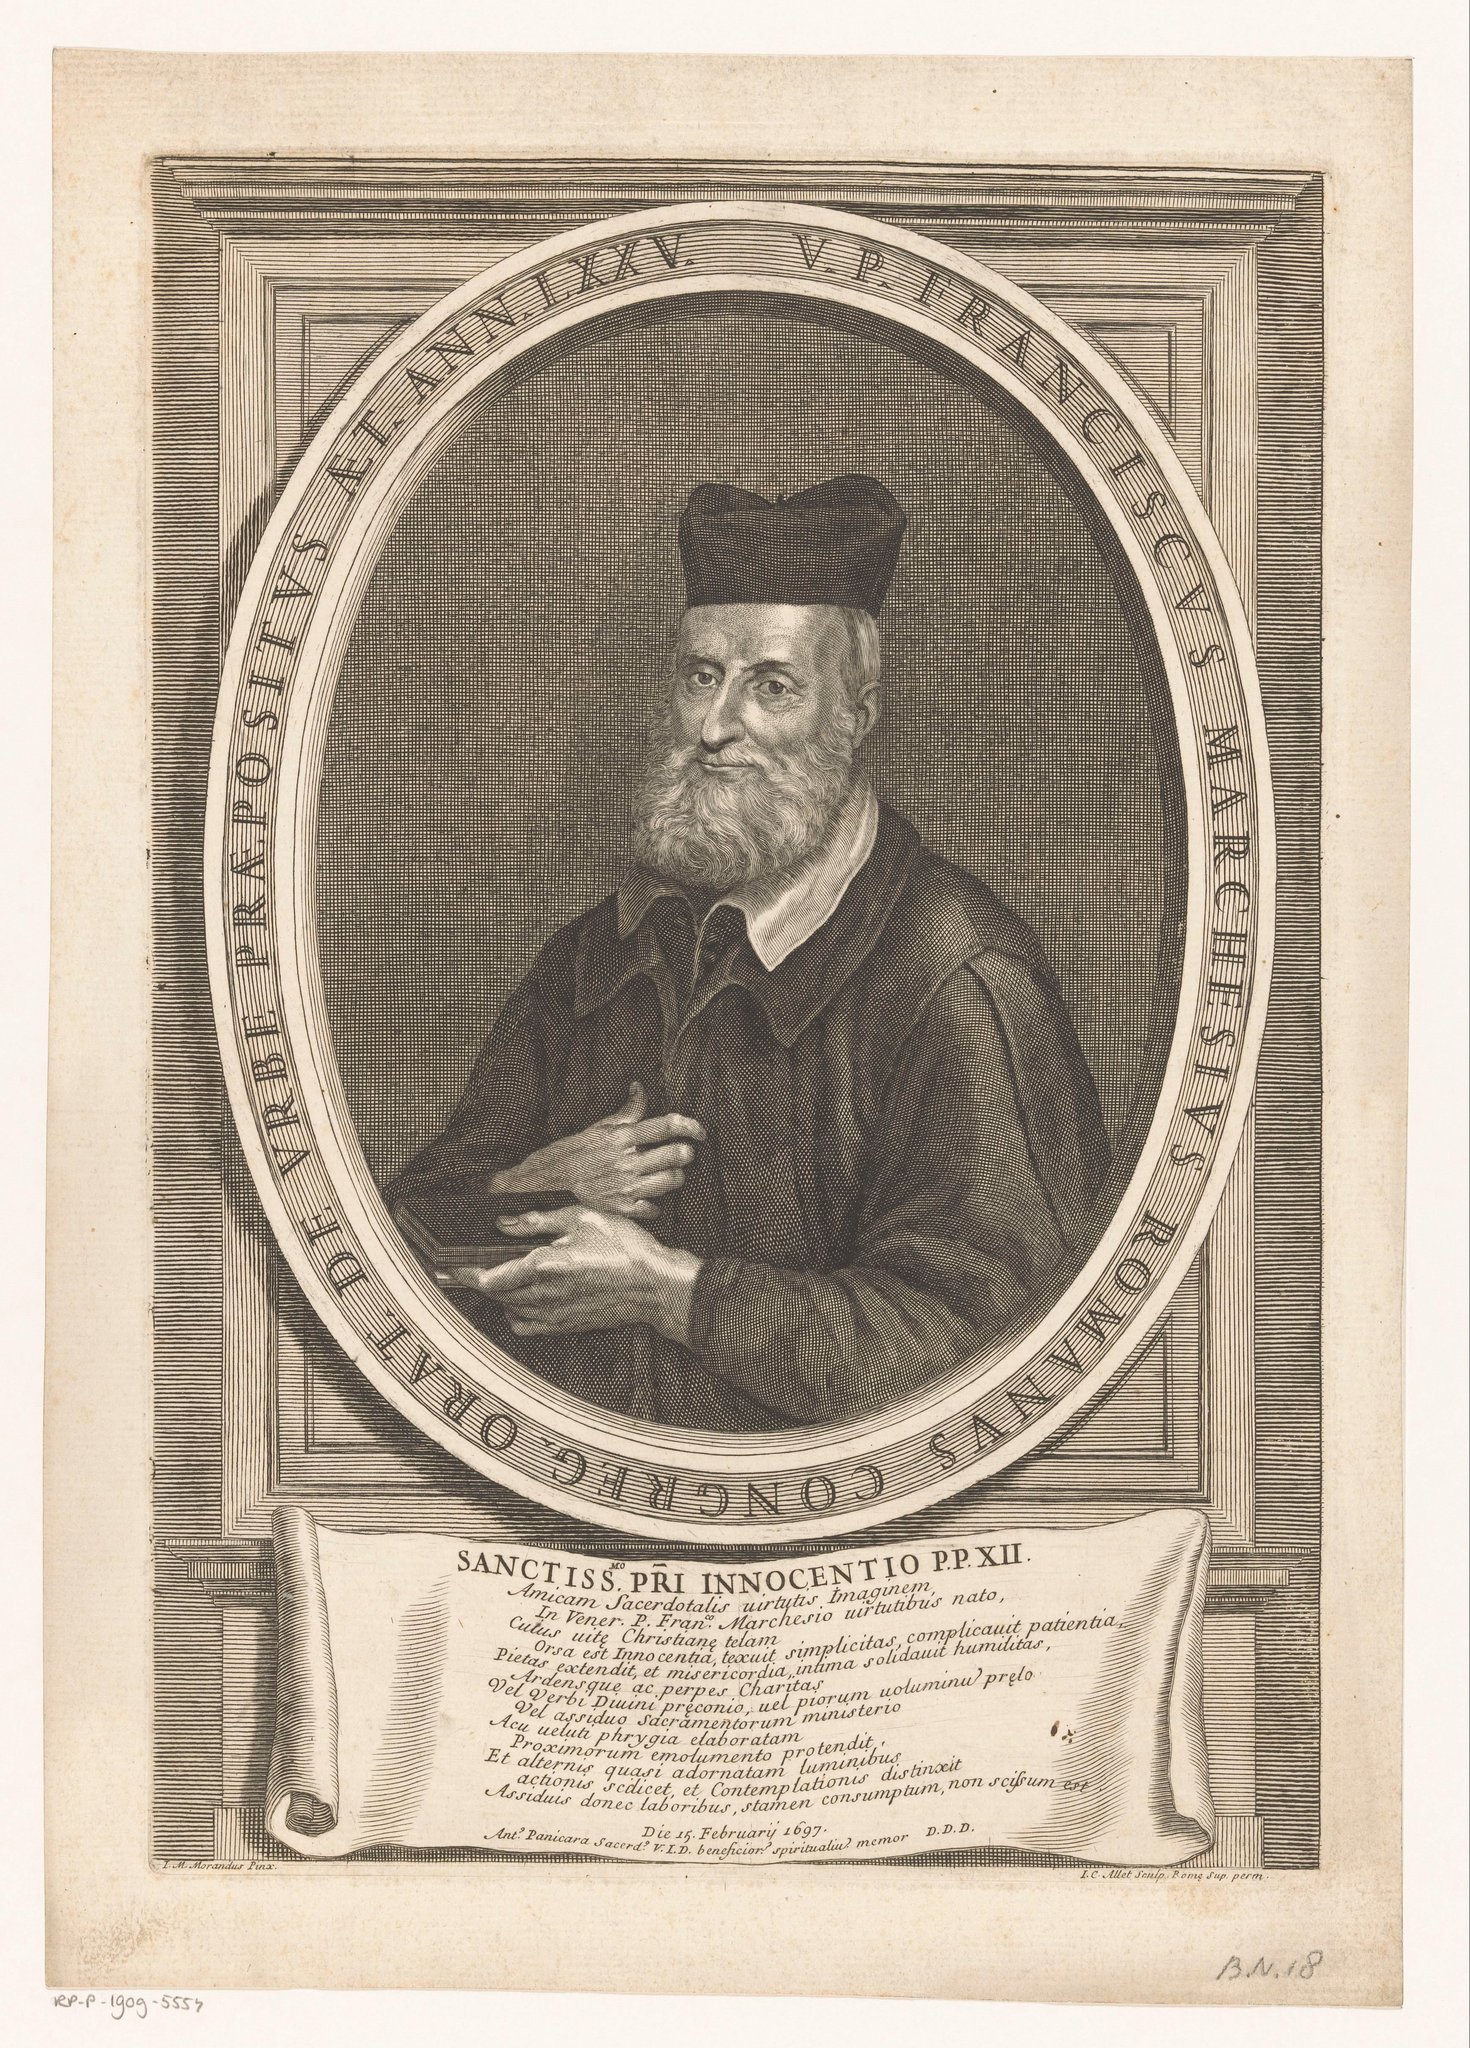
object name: print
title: Portret van Francesco Marchesi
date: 1697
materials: paper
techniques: engraving, etching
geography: rome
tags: clergyman, historical persons, book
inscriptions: collector's mark: Lugt 2228, collector's mark: ‘PA [?]’ Lugt 2067